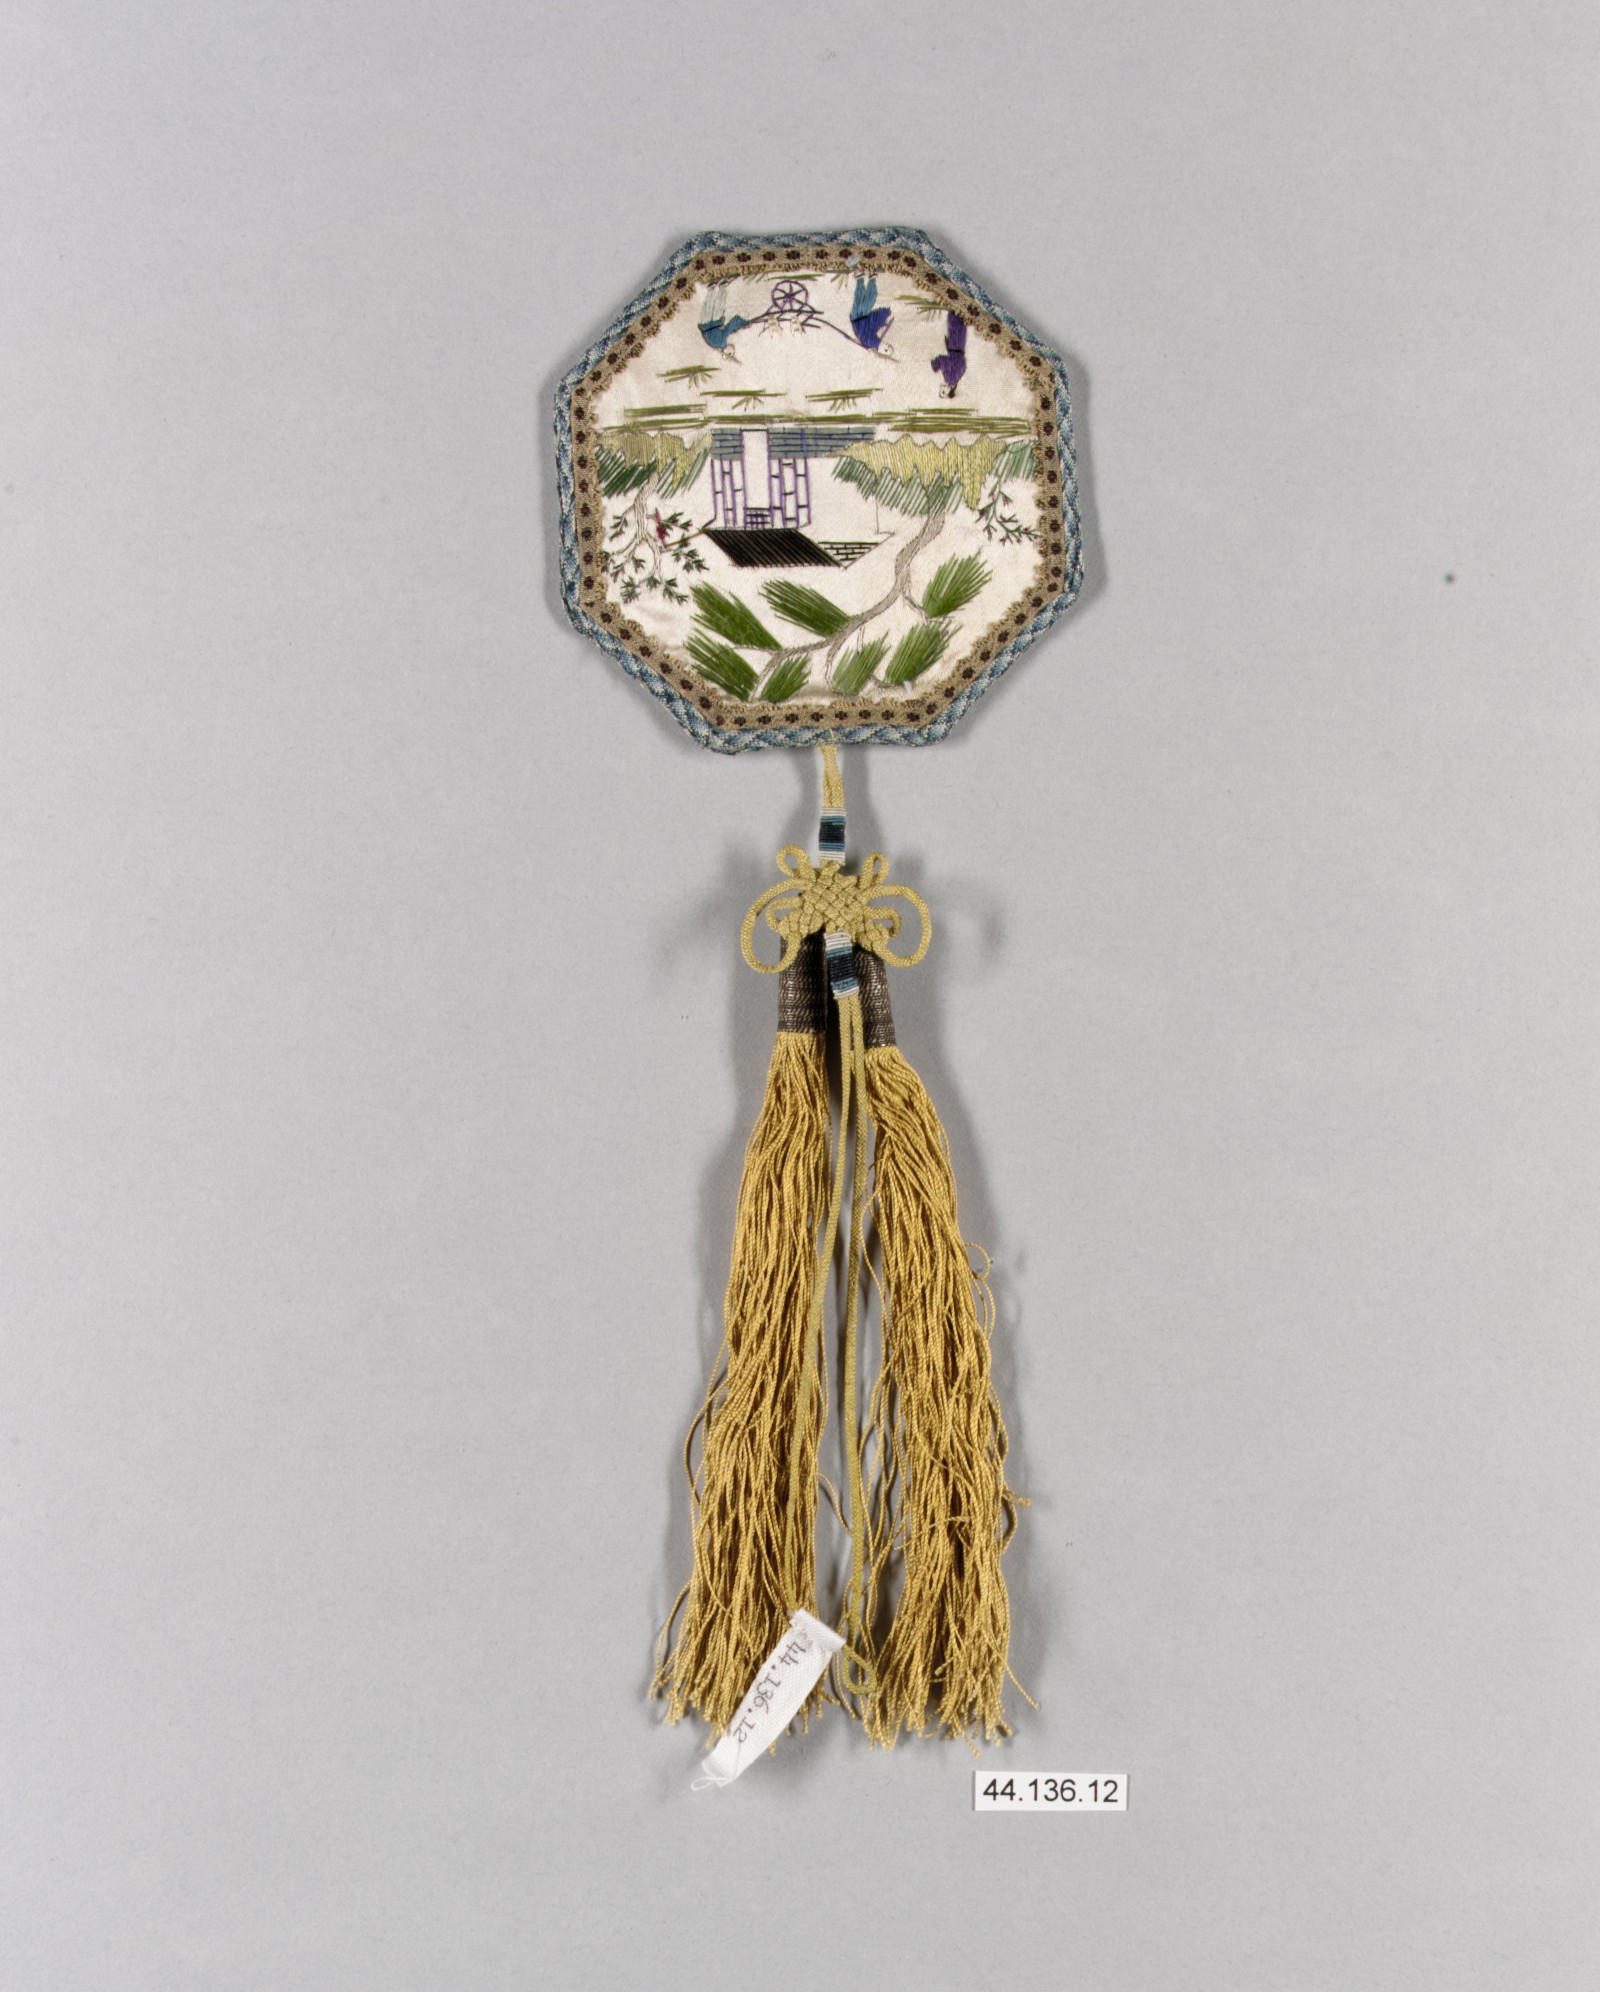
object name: mirror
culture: chinese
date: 1801-1900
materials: glass, silk